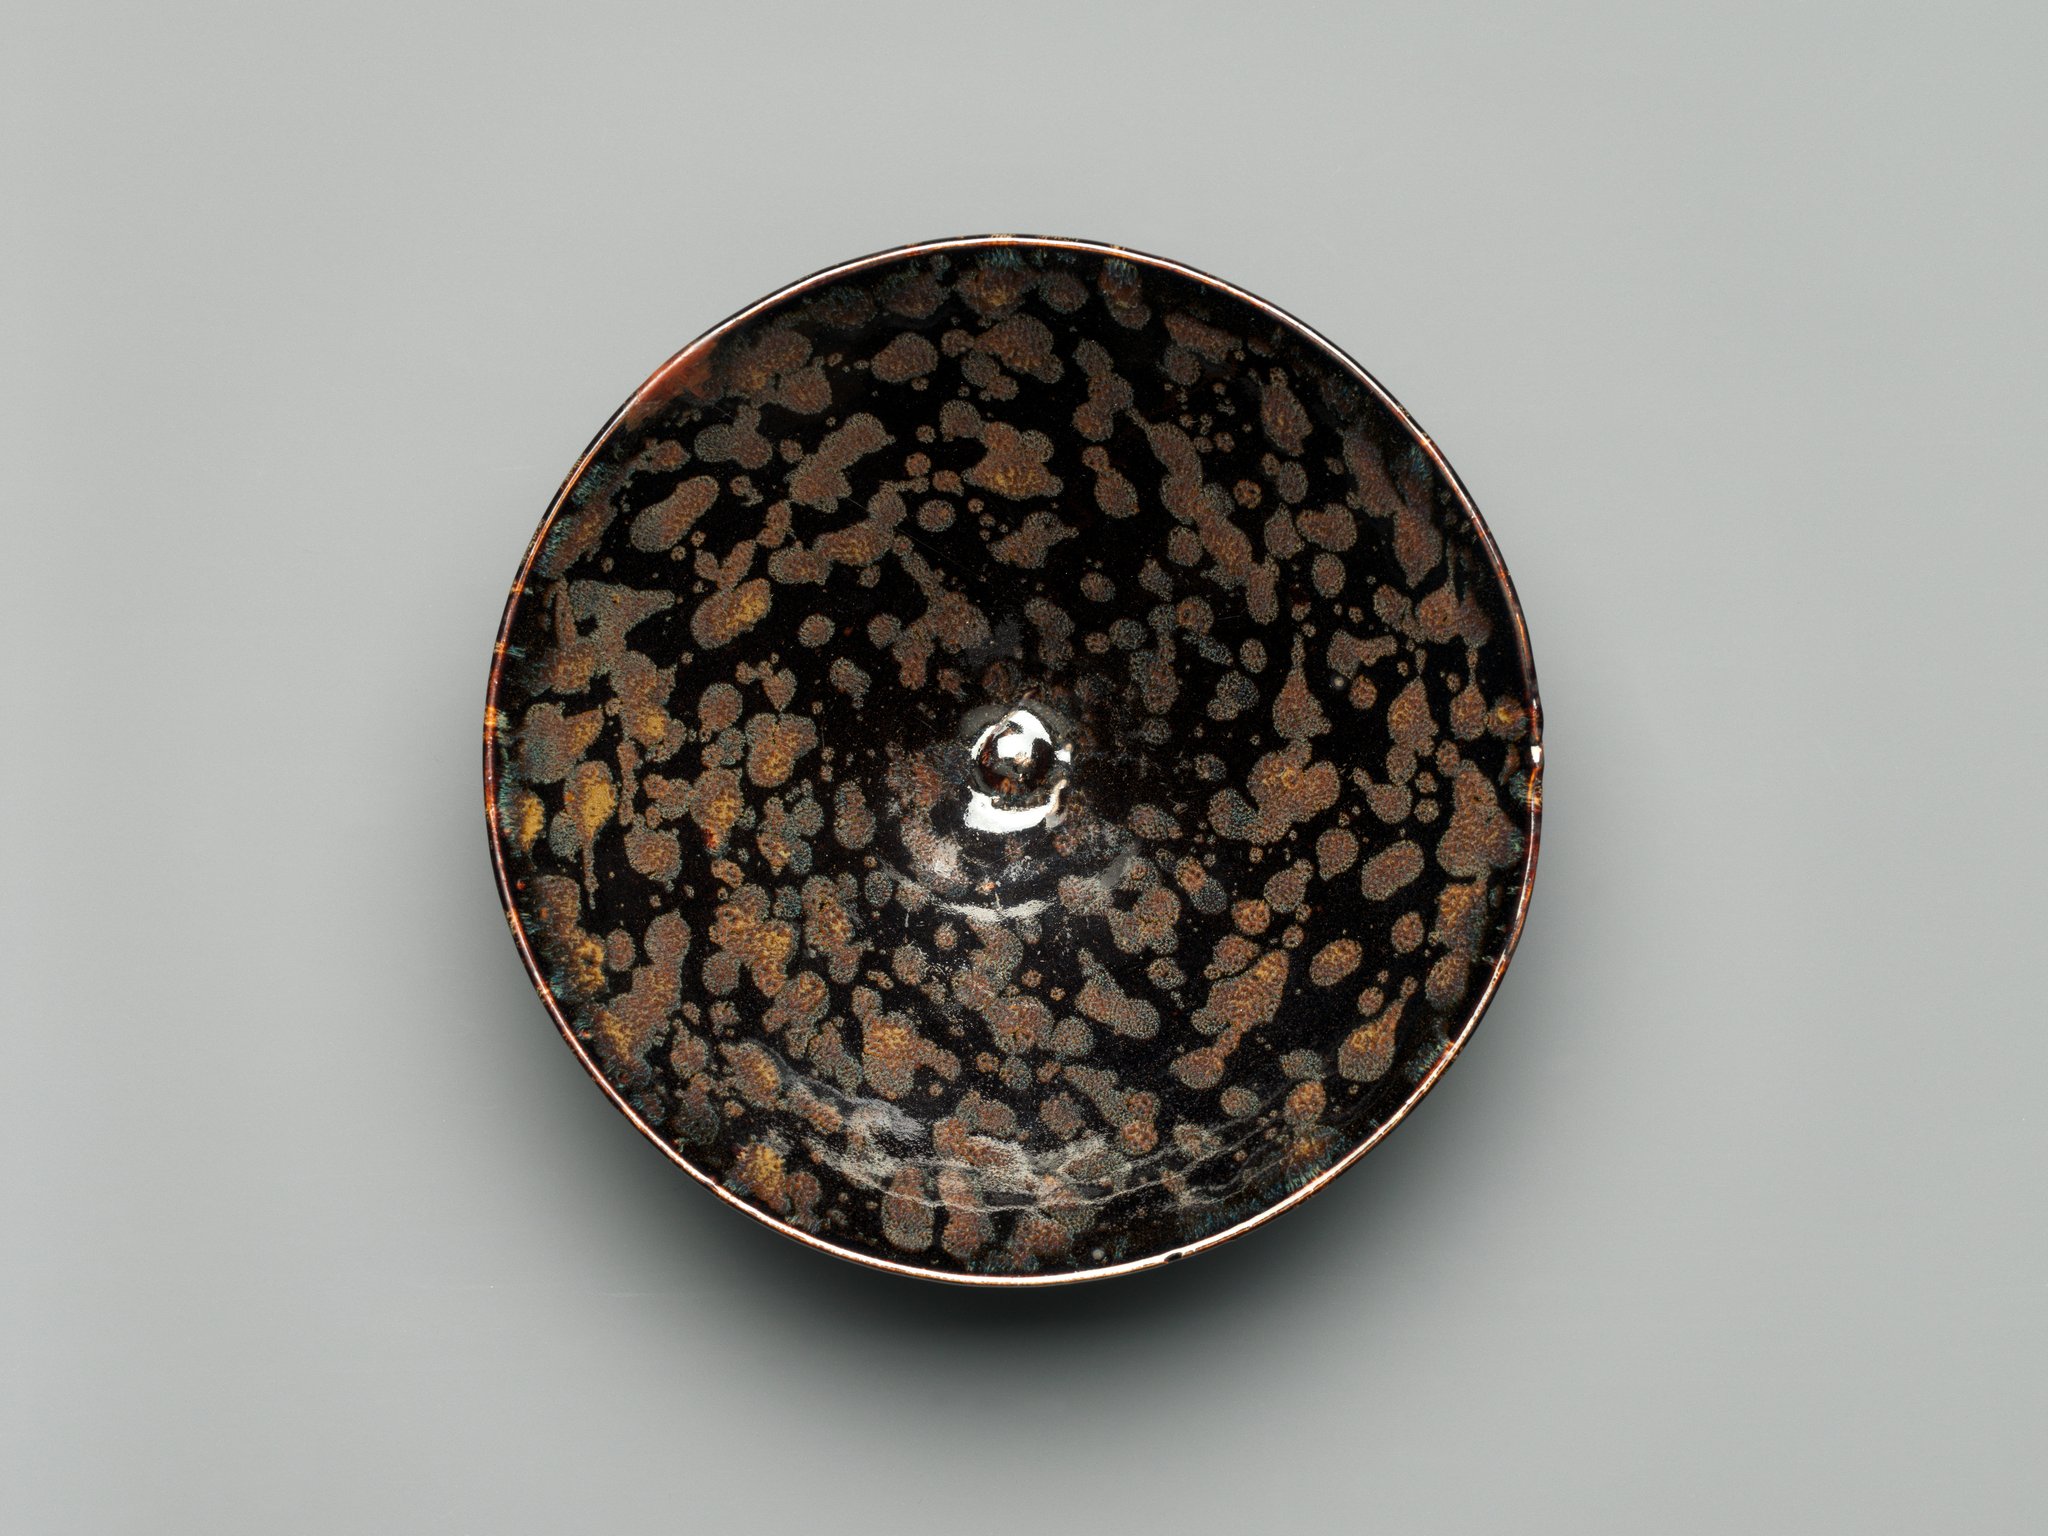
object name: bowl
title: Tea Bowl with “Tortoiseshell” Design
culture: chinese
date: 1201-1400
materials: wood, glaze, iron, stoneware